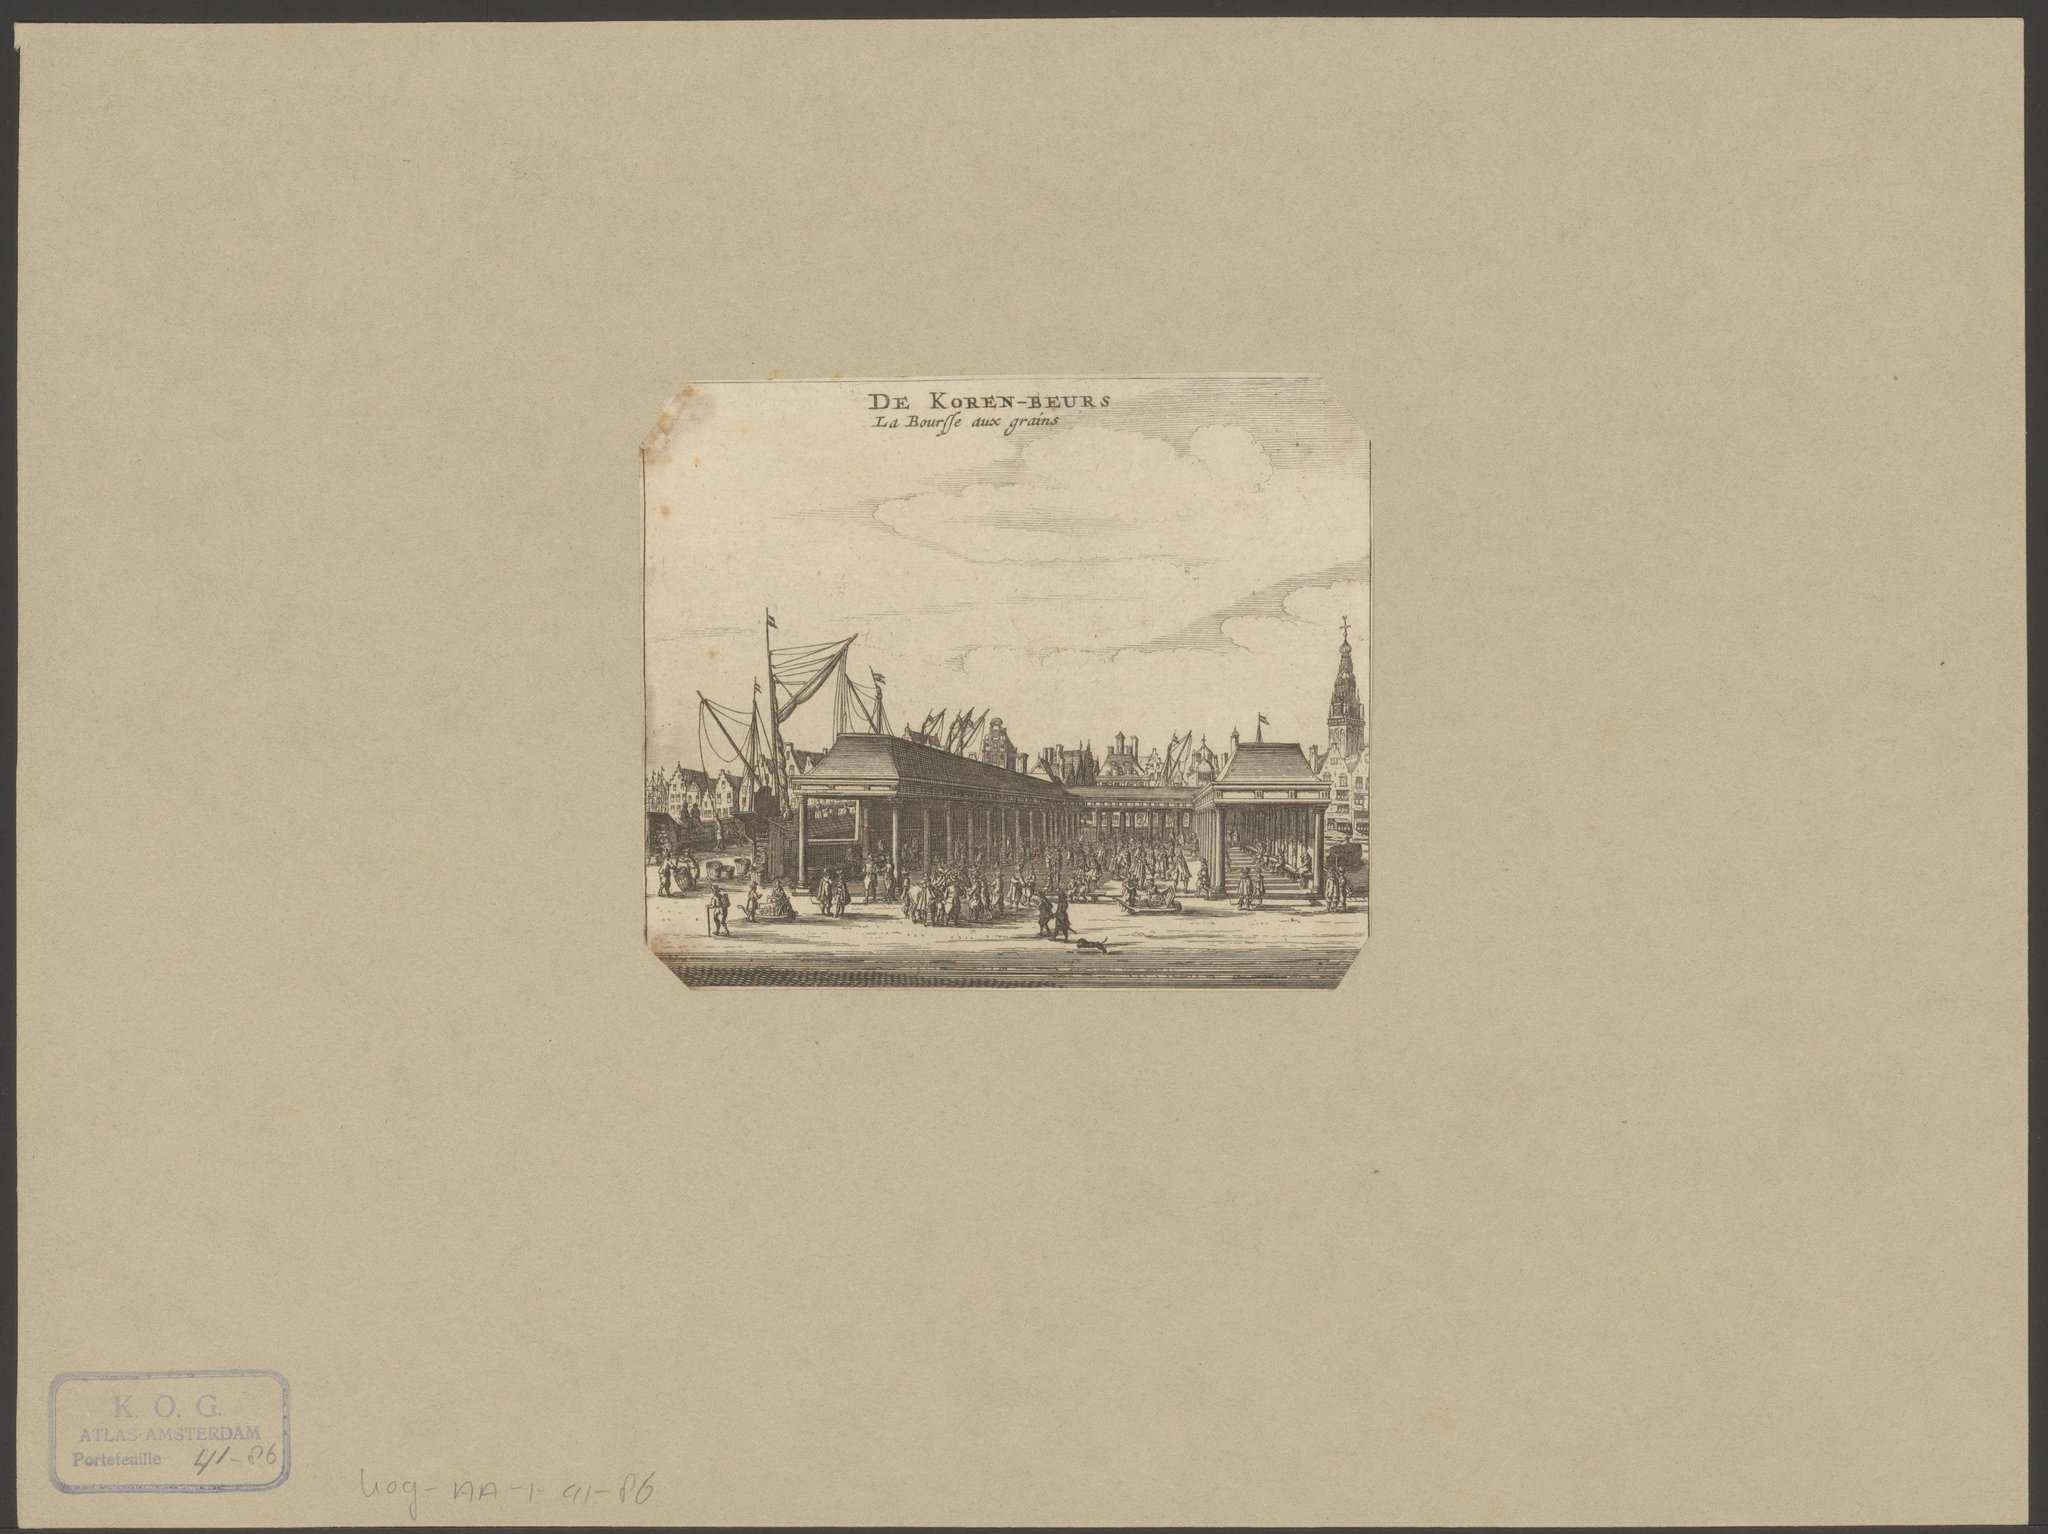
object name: book illustration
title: De Koren-Beurs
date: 1665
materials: paper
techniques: engraving, etching, letterpress printing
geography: amsterdam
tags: sailing-ship, sailing-boat, market-hall, parts of church exterior and annexes: tower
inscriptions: collector's mark: ‘41-86’ Lugt 1641b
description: Huidige staat van prent (met Franse titel) ook gebruikt in: Domselaer, Tobias en Isaac Commelin. Beschryvinge van Amsterdam: haar eerste oorspronk uyt den huyze der heeren van Aemstel en Aemstellant (…). 6 dln. Amsterdam: Marcus Willemsz van Doornick, 1665, dl. 3, p. 173.